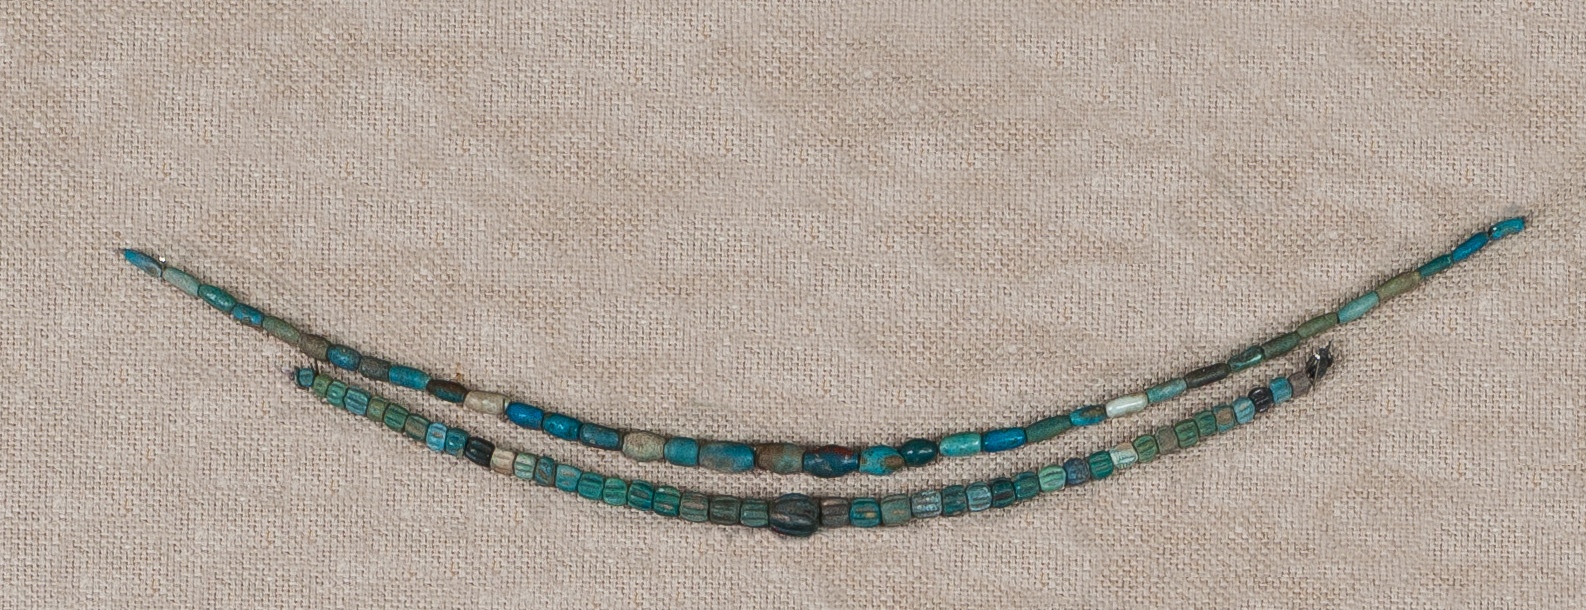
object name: necklace, bead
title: String of beads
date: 1981-1295 BCE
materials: faience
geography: egypt